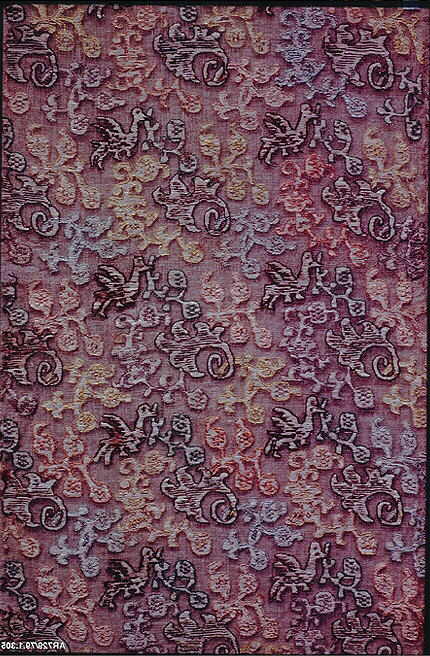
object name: piece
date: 1801-1900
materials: cotton, silk